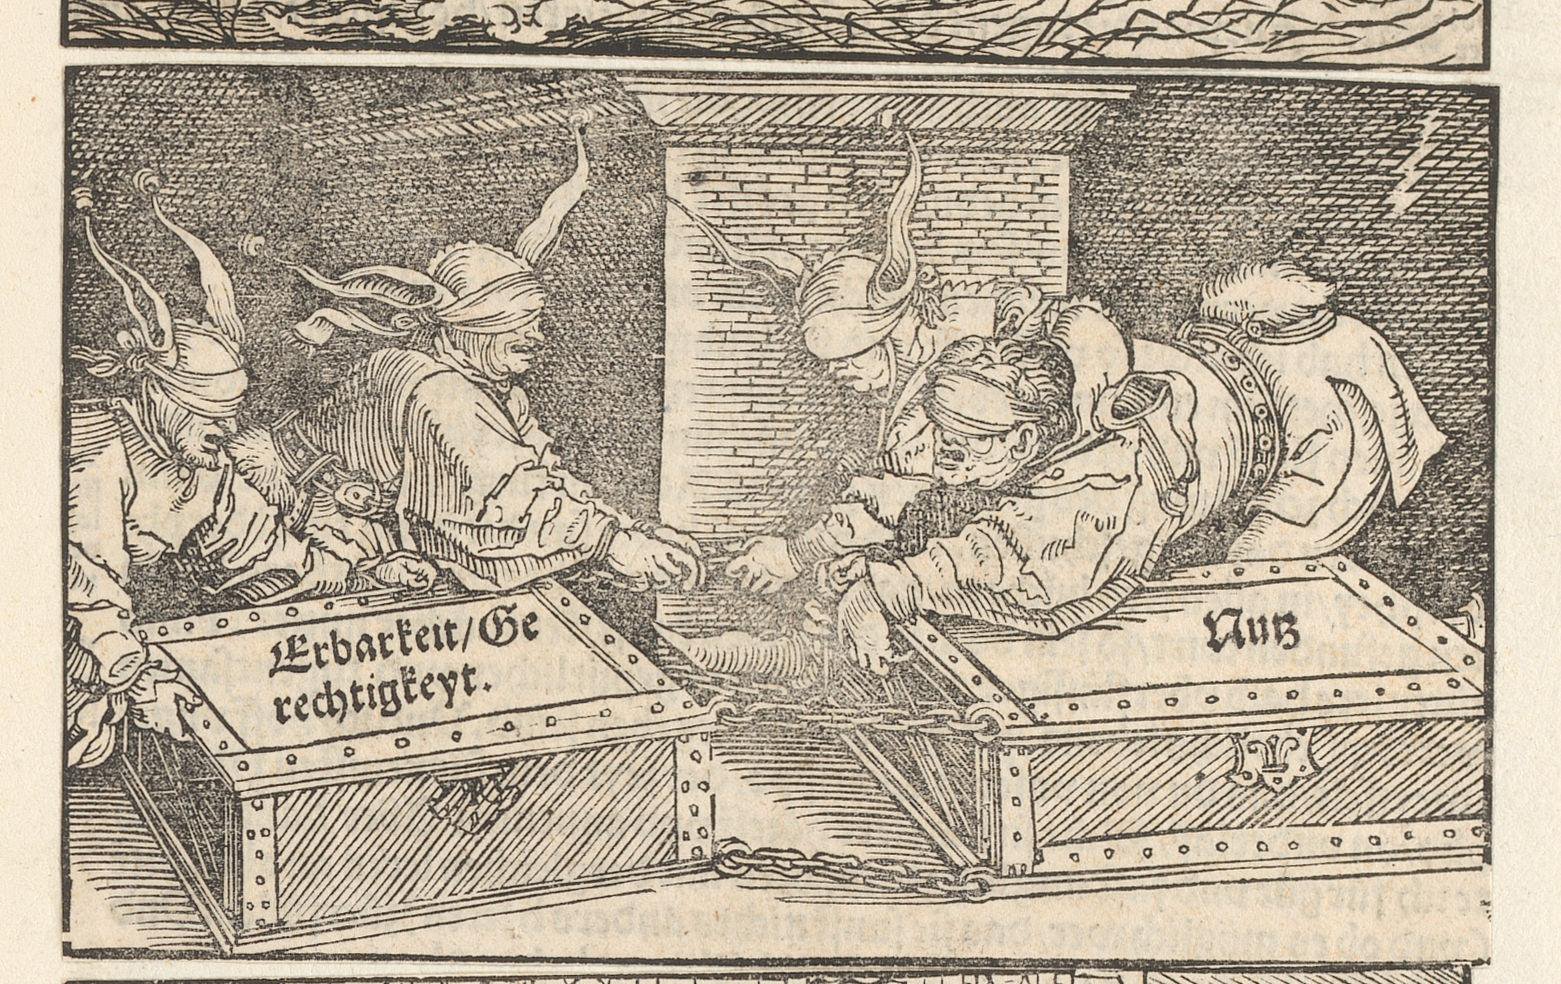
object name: print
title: Geblinddoekte mannen met ezelsoren bij twee aan elkaar geketende kisten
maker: Anonymous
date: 1514-1532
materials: paper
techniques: letterpress printing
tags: court jester, court fool, virtuousness; 'amor di virtù', 'attione virtuosa', 'guida sicura de' veri honori', 'virtù', 'virtù insuperabile' (ripa), wisdom of the fool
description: Deze prent is gebruikt in: Petrarca, Francesco. Von der Artzney bayder Glück, des guten und widerwertigen: unnd weß sich ain yeder inn Gelück und Unglück halten sol (...). Augsburg: Heinrich Steiner, 1532. Deze uitgave is ook bekend onder de titel 'Trostspiegel in Glück und Unglück'.